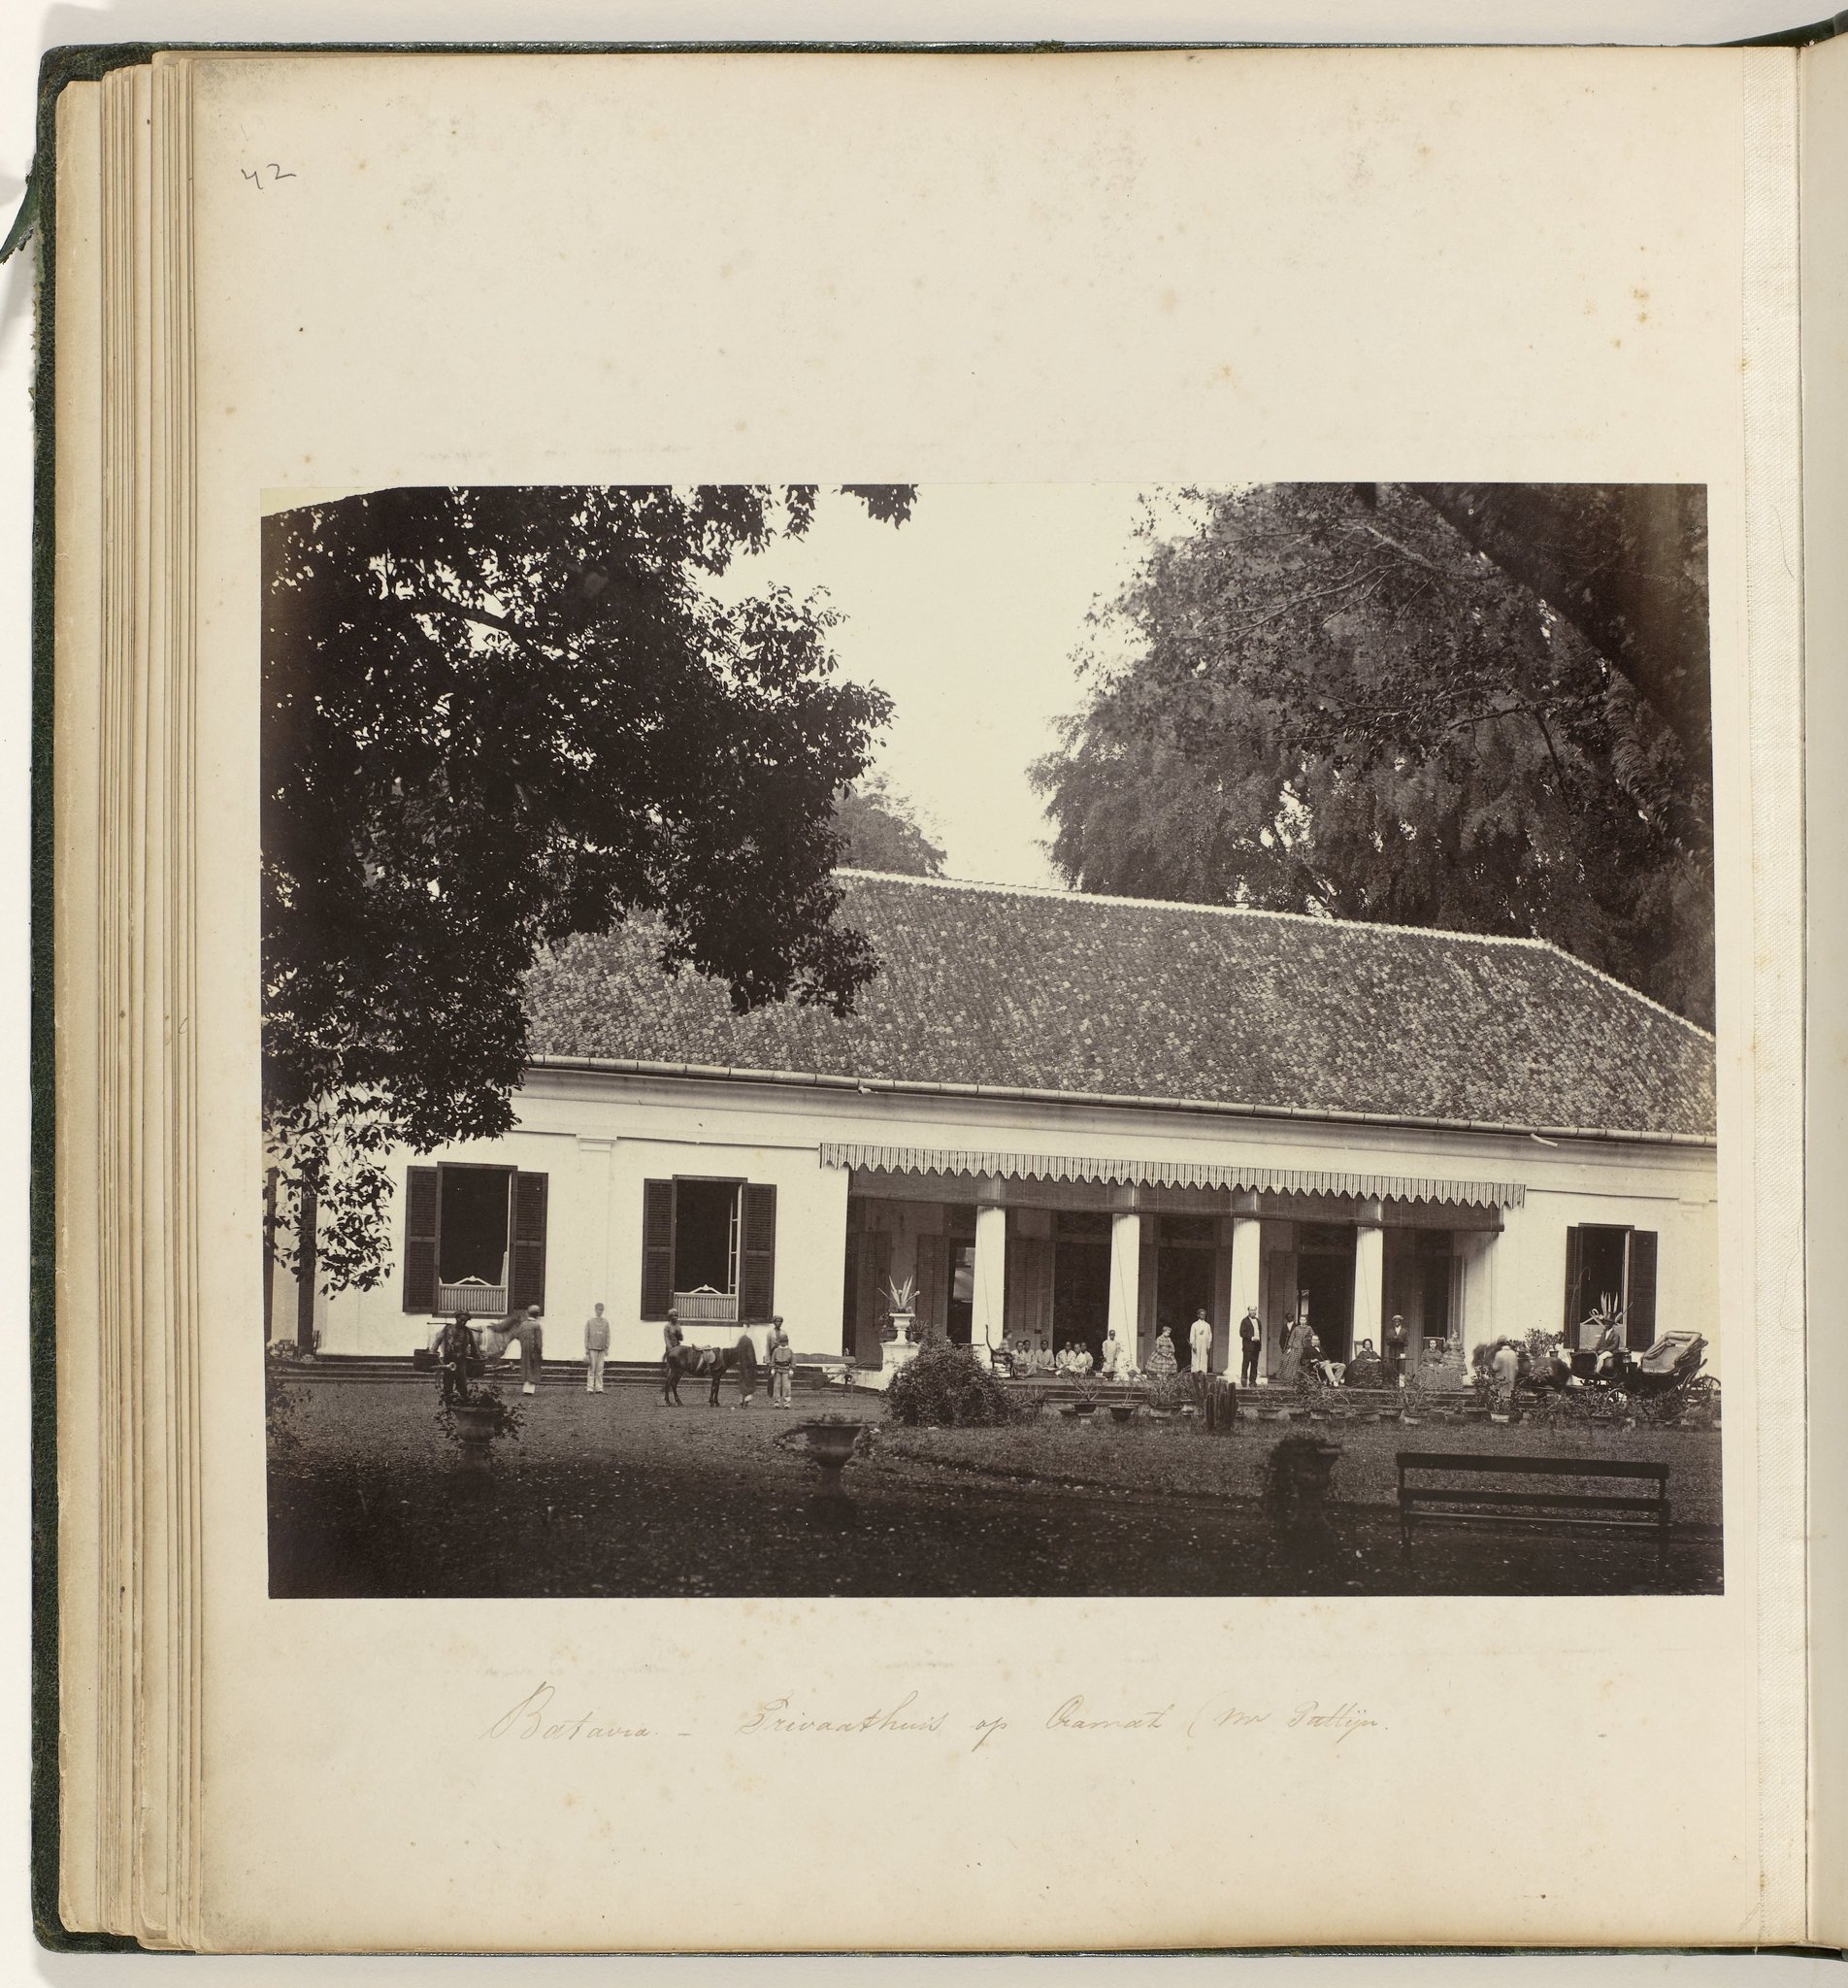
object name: photograph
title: Batavia - Privaathuis op Cramat (Mr. Pattijn.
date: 1863-1866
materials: photographic support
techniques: albumen print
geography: batavia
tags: detached house in city, batavia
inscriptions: inscription: ‘Batavia - Privaathuis op Cramat (Mr. Pattijn.’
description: Gezicht op het woonhuis van de heer Pattijn in de wijk Kramat in Batavia. Familie en personeel poseren op de veranda voor het huis. Onderdeel van het tweede groene fotoalbum met foto's van Java, uit het bezit van apotheker Specht-Grijp, die in 1865 vanuit Batavia naar Nederland terugkeerde.